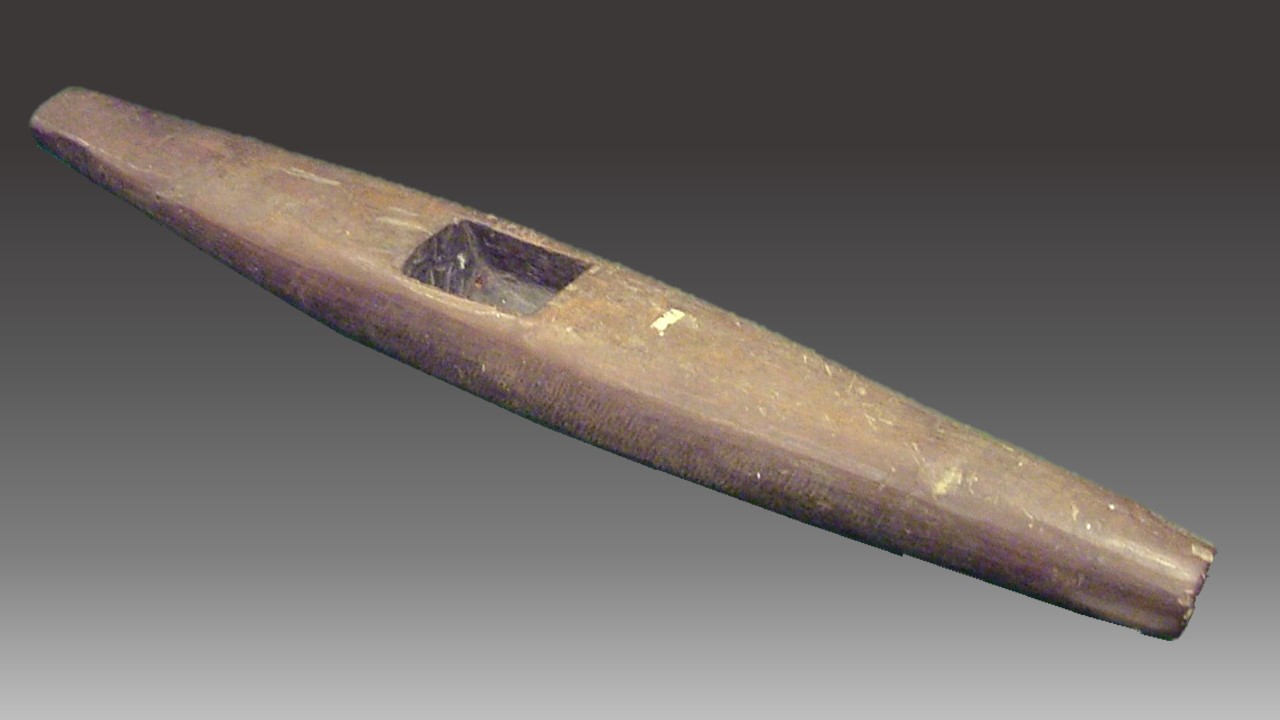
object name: lali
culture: melanesian, fijian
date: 1867-1900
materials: wood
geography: fiji